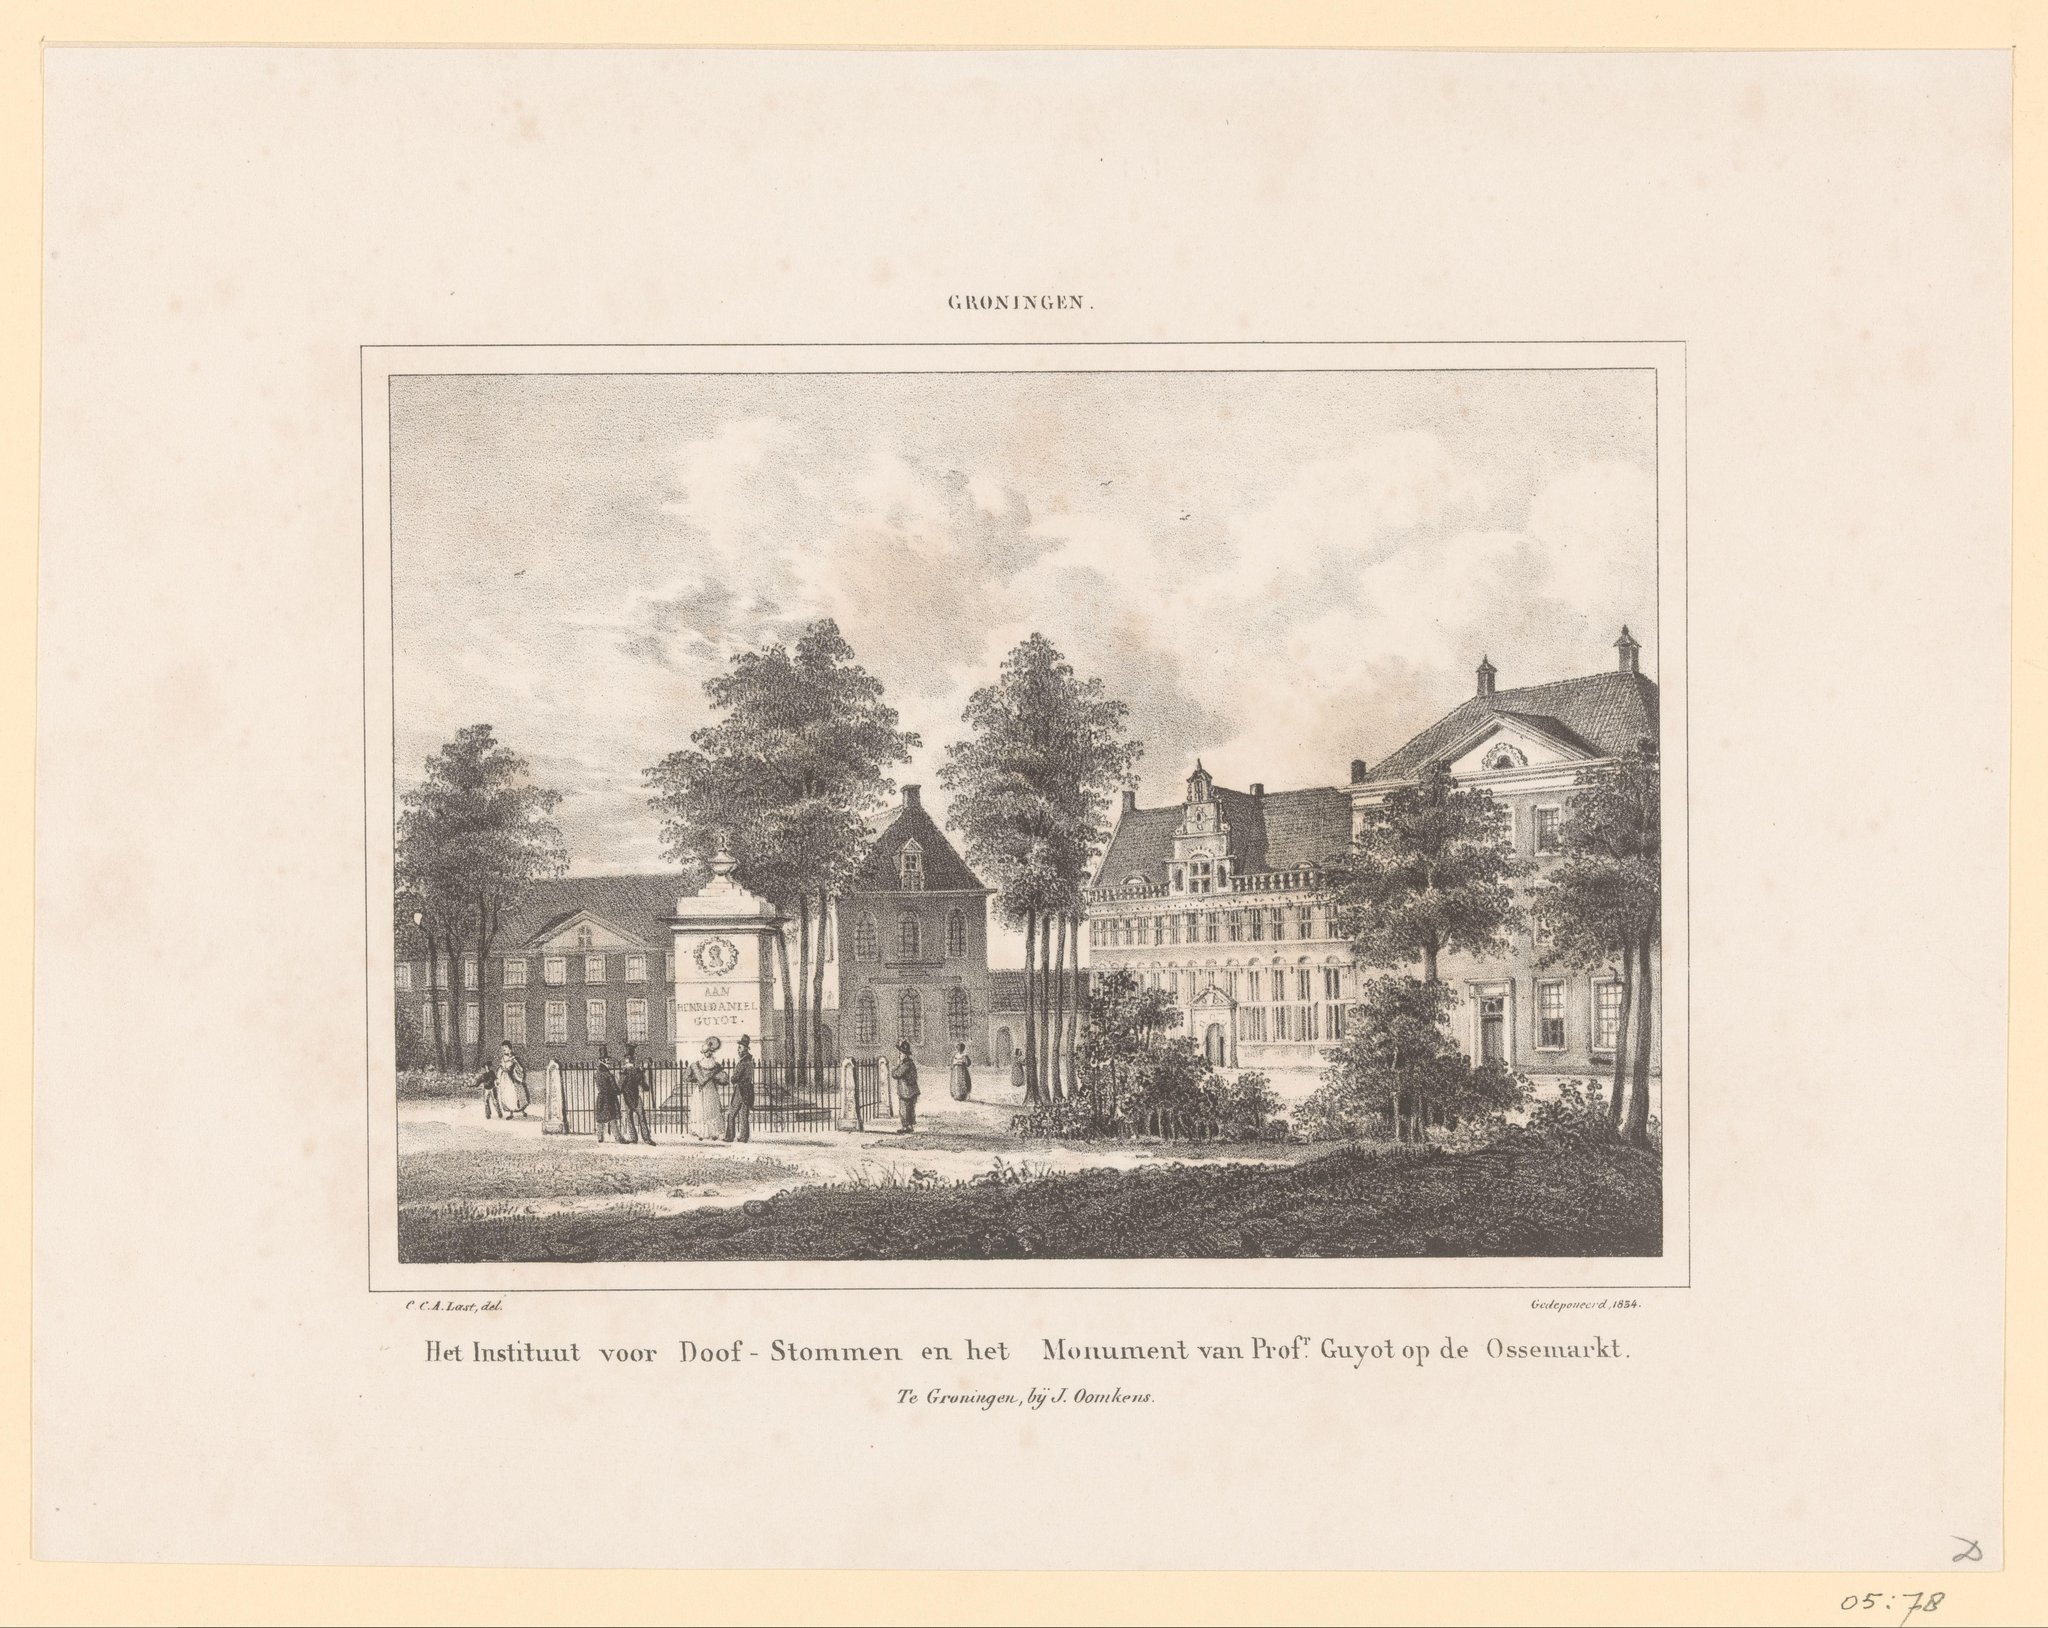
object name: print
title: Het Instituut voor doof-stommen en het monument van Prof. Guyot op de Ossemarkt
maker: jan oomkens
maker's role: bookseller, printer, publisher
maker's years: 1779-1844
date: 1834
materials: paper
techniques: lithograph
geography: groningen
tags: france, deaf and non-verbal, formerly known as 'deaf-mute', deaf, deafness, specialized institutions, monument, statue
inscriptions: collector's mark: Lugt 2228